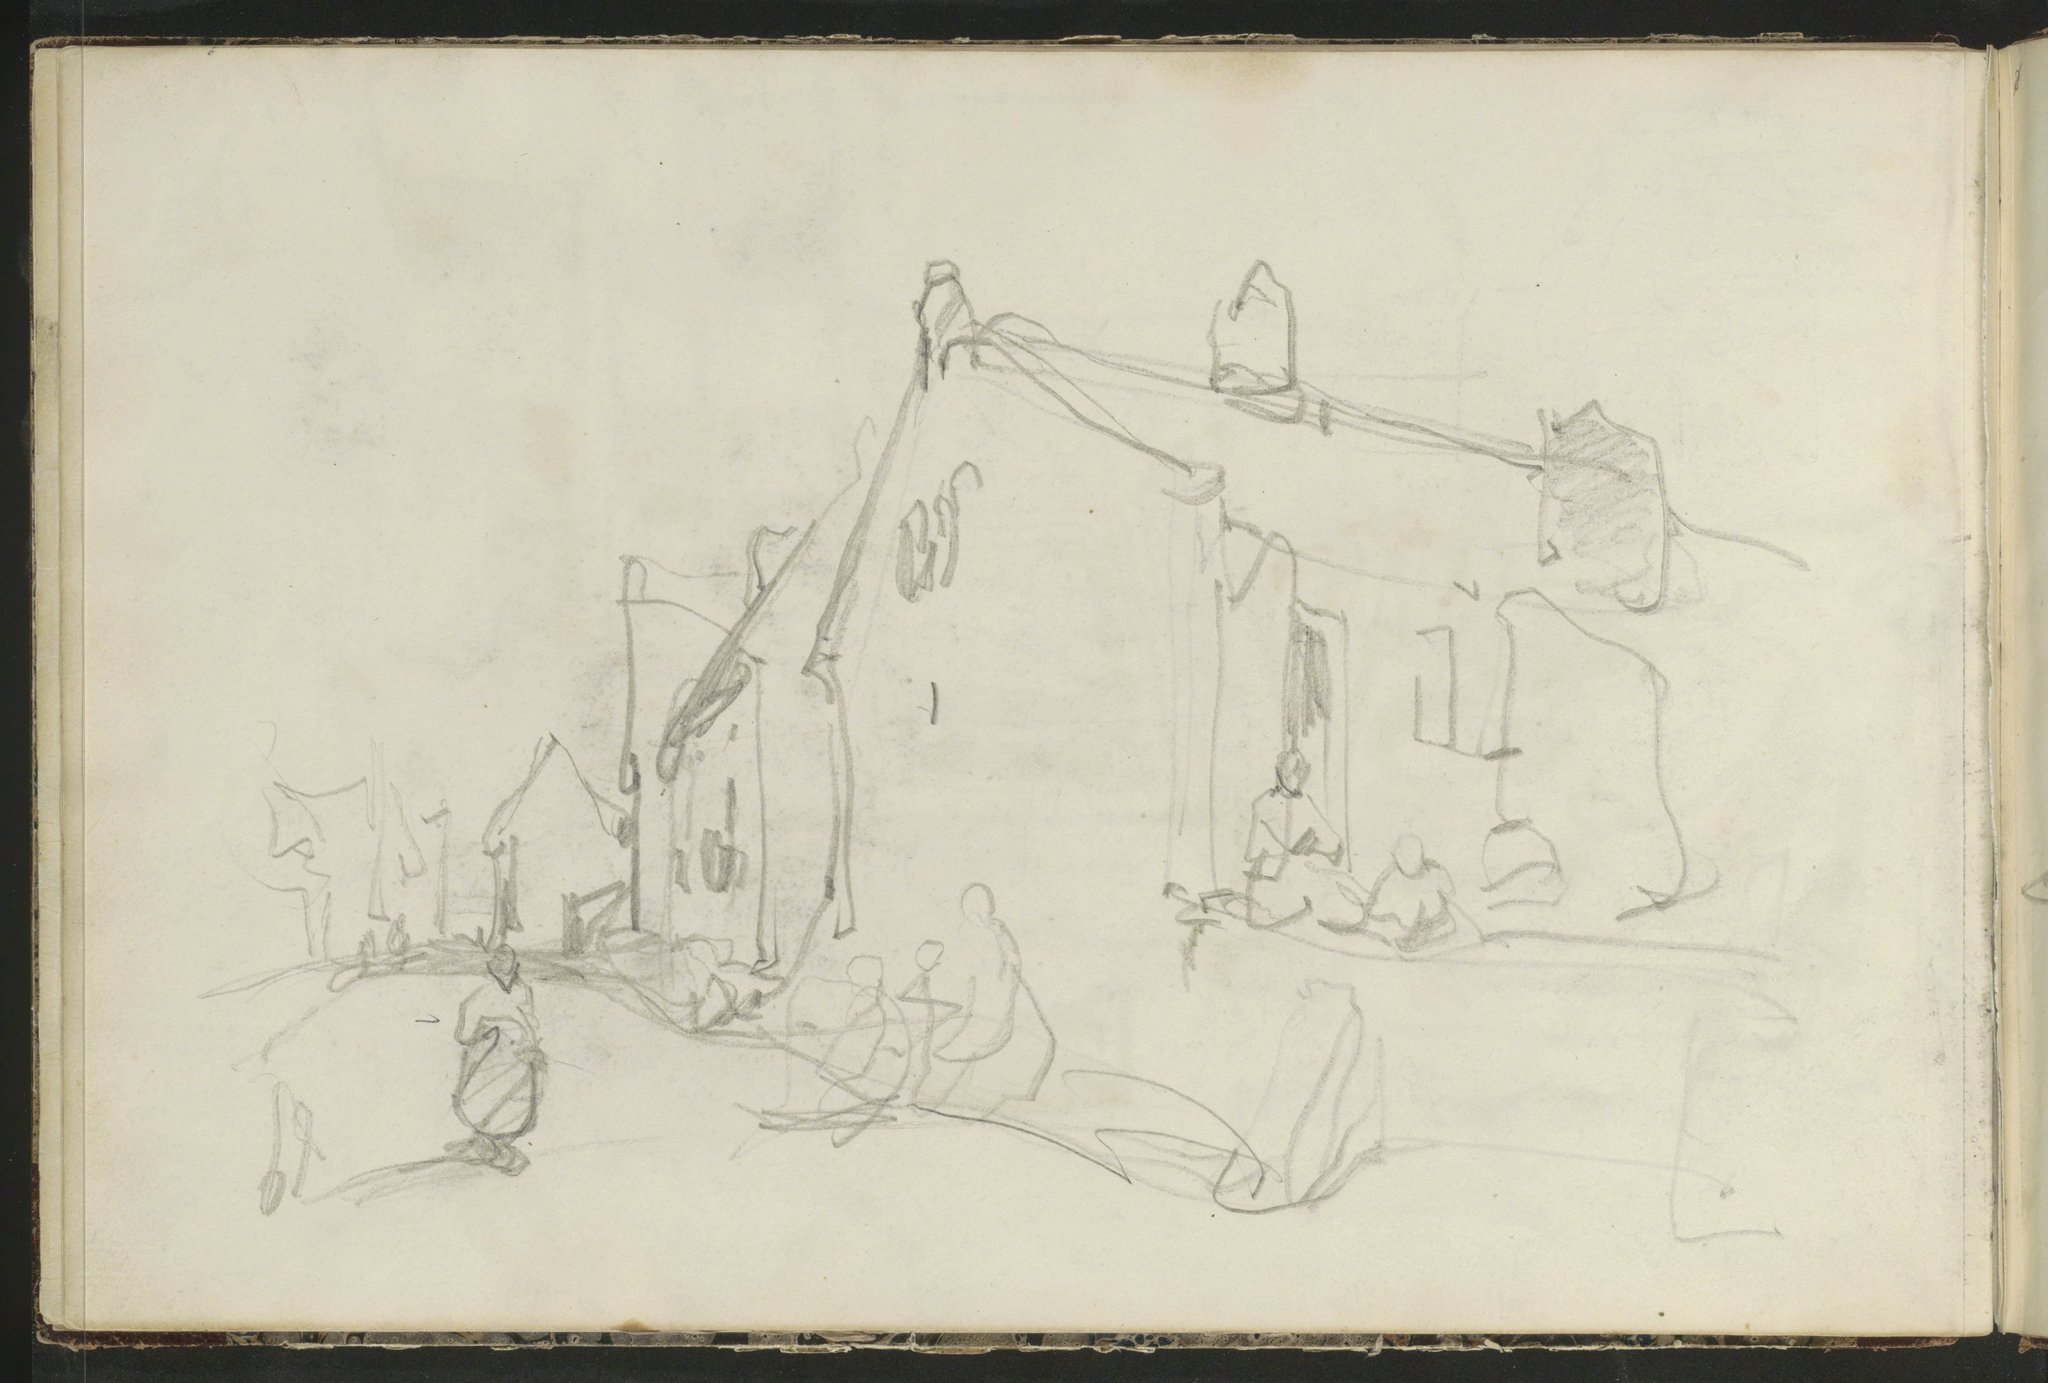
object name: sketchbook leaf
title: Straat met figuren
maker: johannes bosboom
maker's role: draughtsman, painter, print maker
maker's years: 1817-1891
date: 1827-1891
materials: paper, pencil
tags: street (+ city(-scape) with figures, staffage)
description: Blad 5 verso uit een schetsboek met 11 bladen.